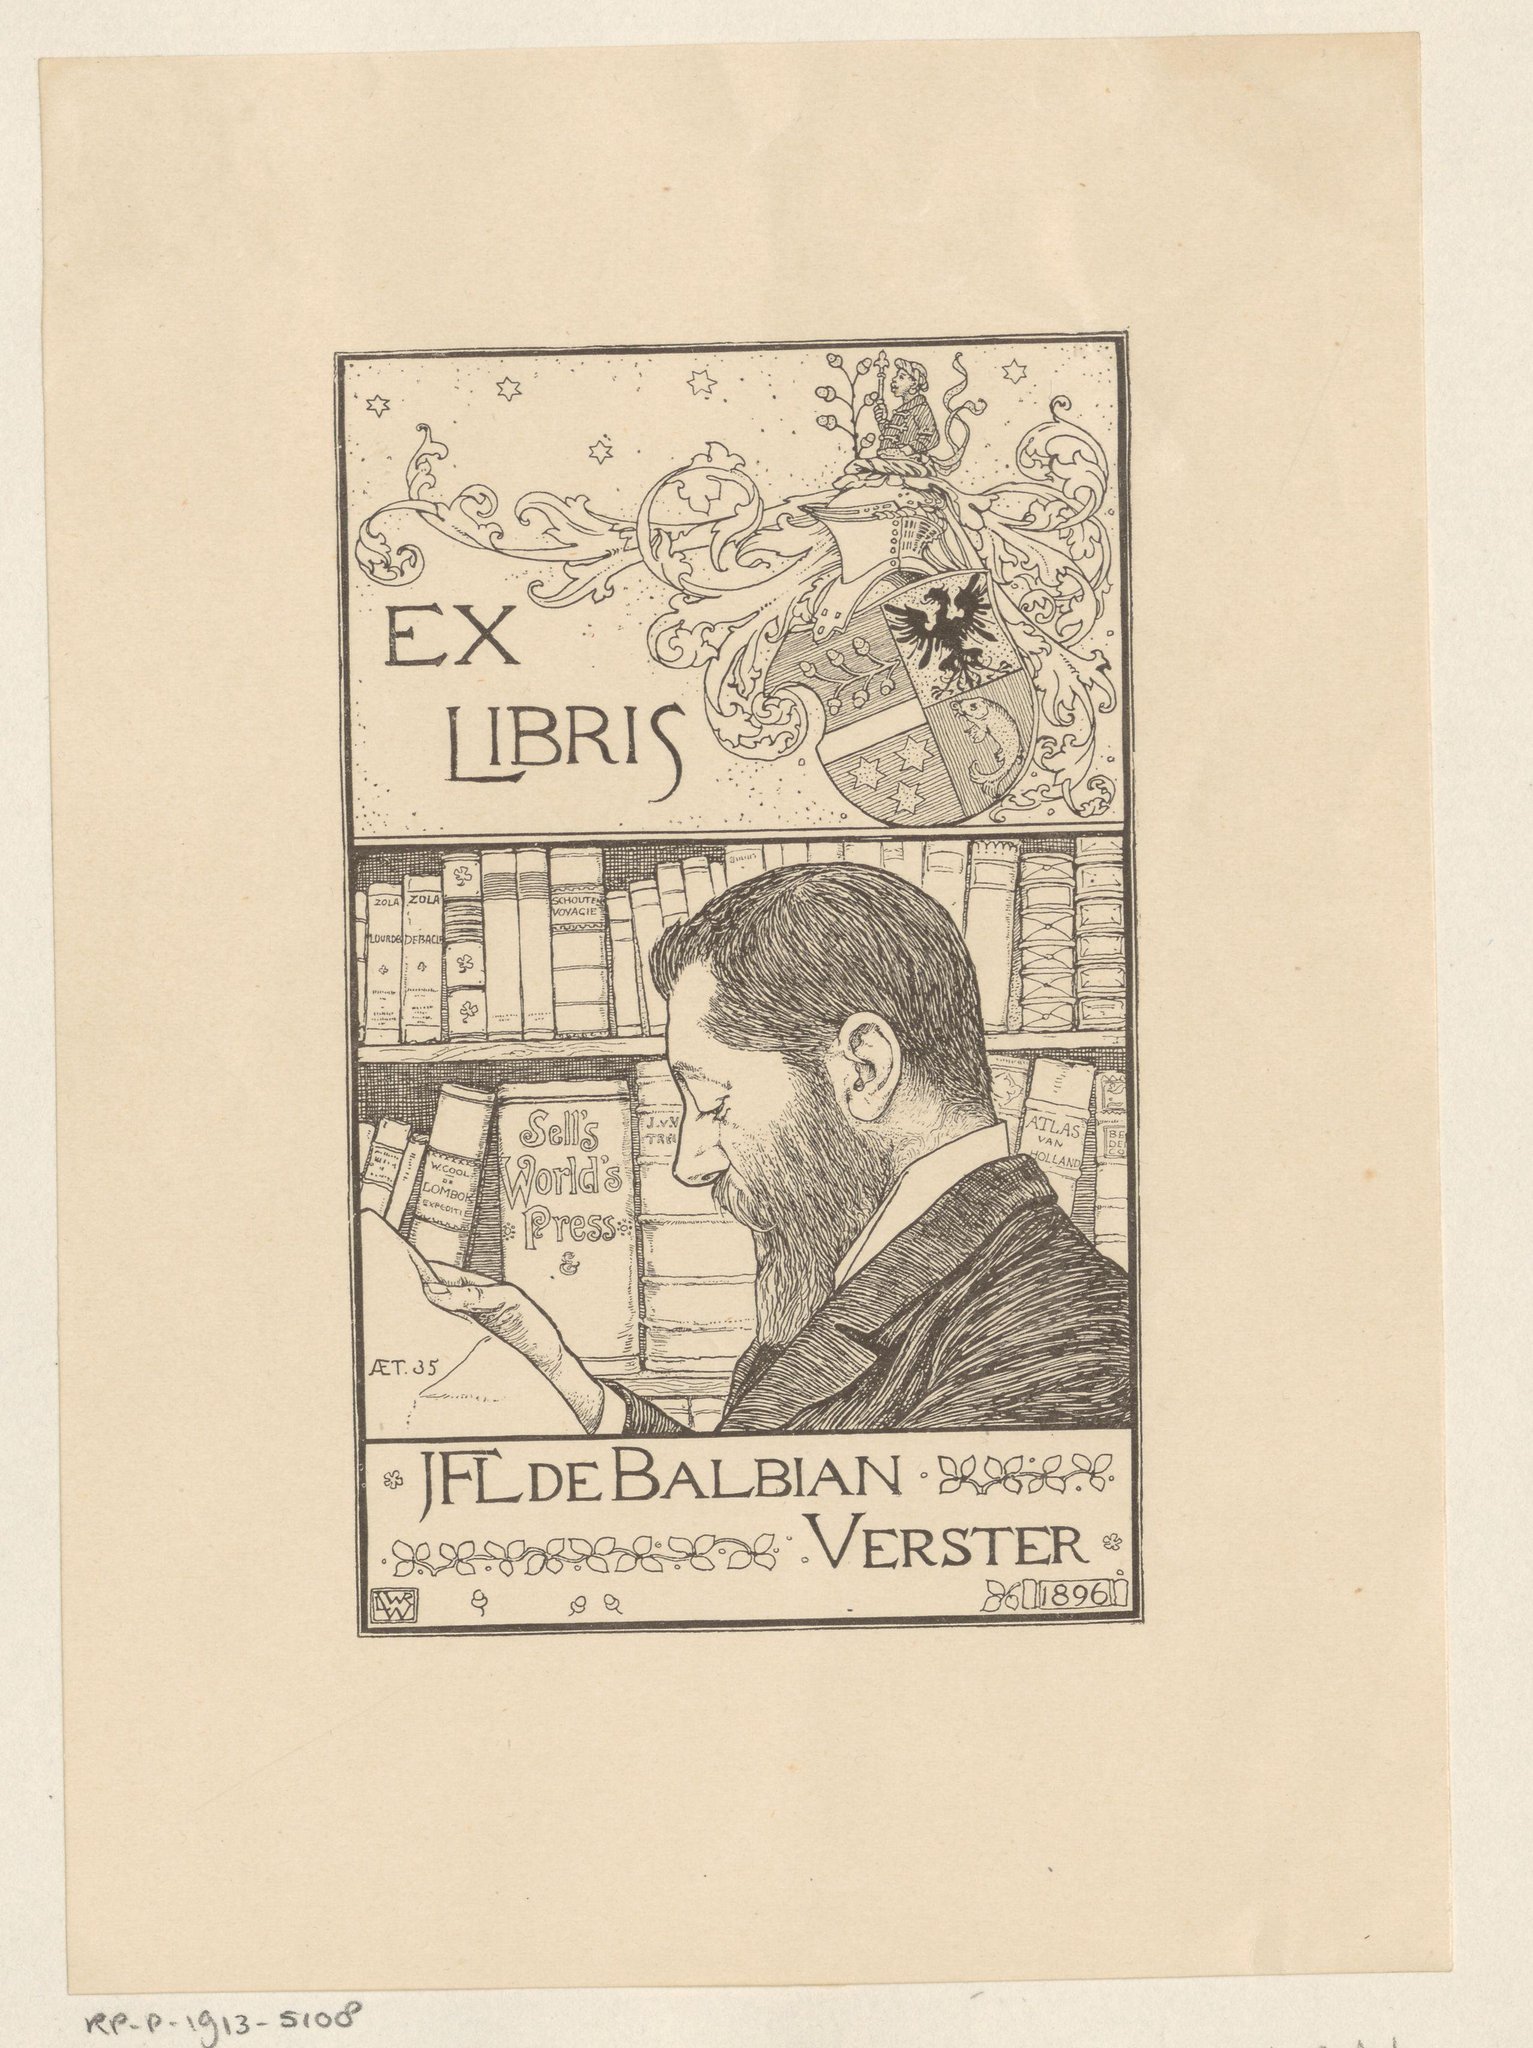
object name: bookplate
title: Ex libris van J.F.L. de Balbian Verster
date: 1896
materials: paper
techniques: printing block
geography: netherlands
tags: amsterdam, bookshelves, reading, book, head turned sideways, armorial bearing, heraldry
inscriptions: collector's mark: Lugt 2233, collector's mark: Lugt 2760